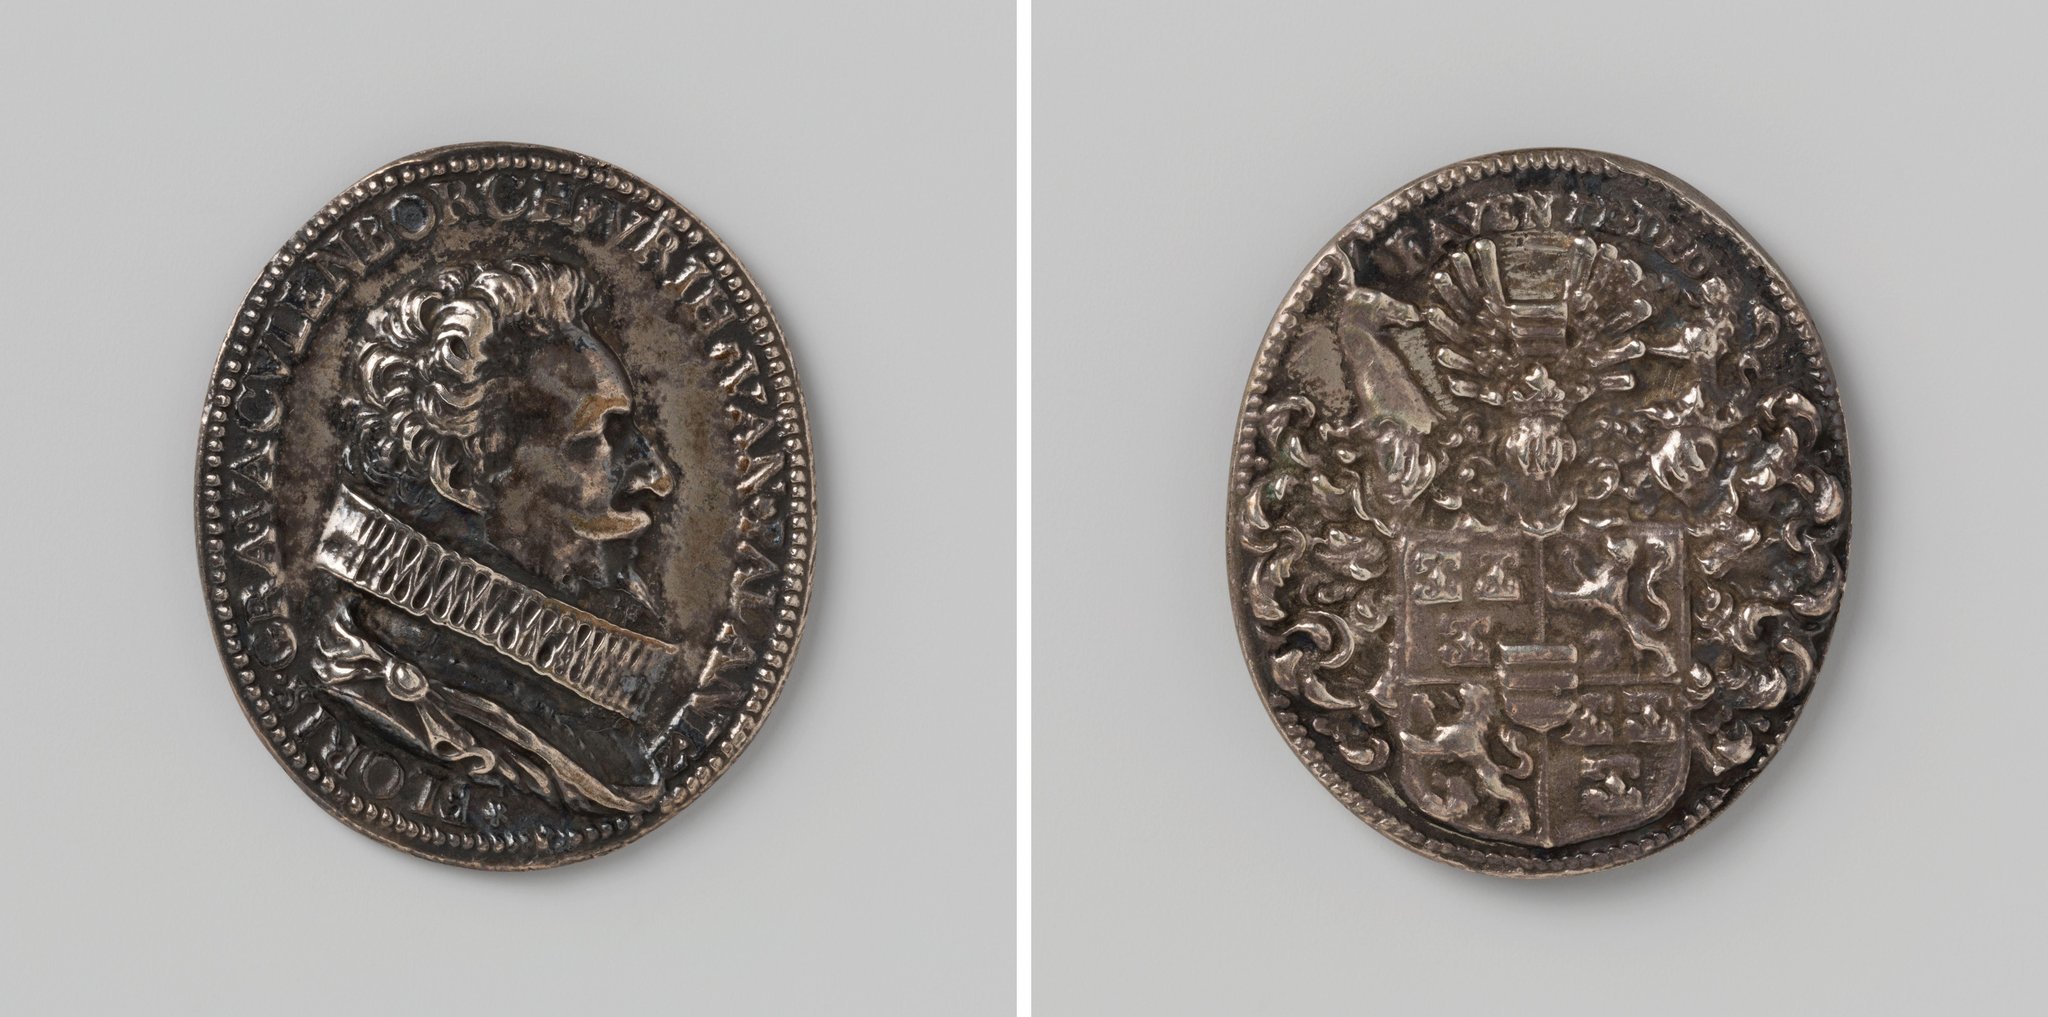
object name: history medal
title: Floris II van Pallandt, graaf van Culemborg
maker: adriaen symonsz. rottermont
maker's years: 1579-1652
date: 1622-1624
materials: silver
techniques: casting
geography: the hague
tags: earl, floris ii van pallandt (graaf van culemborg)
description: Zilveren ovale penning. Voorzijde: borststuk man binnen omschrift. Keerzijde: wapenschild met drie helmen binnen omschrift.